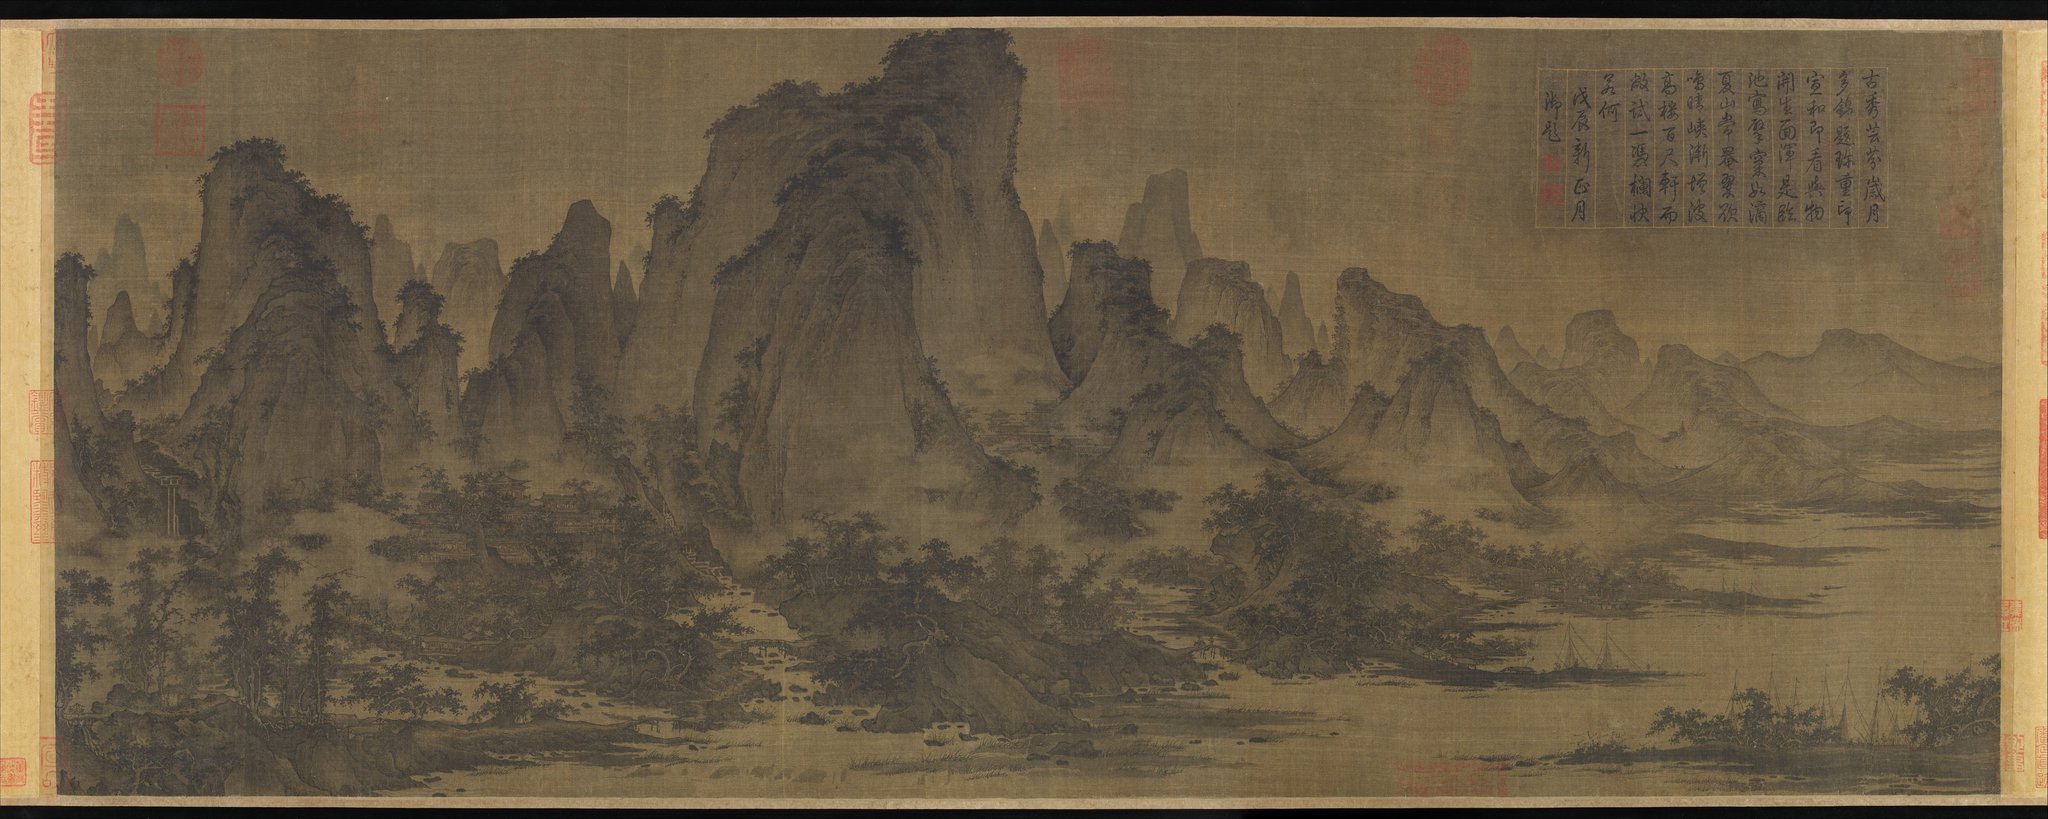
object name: handscroll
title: Summer Mountains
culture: chinese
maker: qu ding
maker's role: artist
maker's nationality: chinese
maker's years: 950-1150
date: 1050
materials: ink, silk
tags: mountains,landscapes